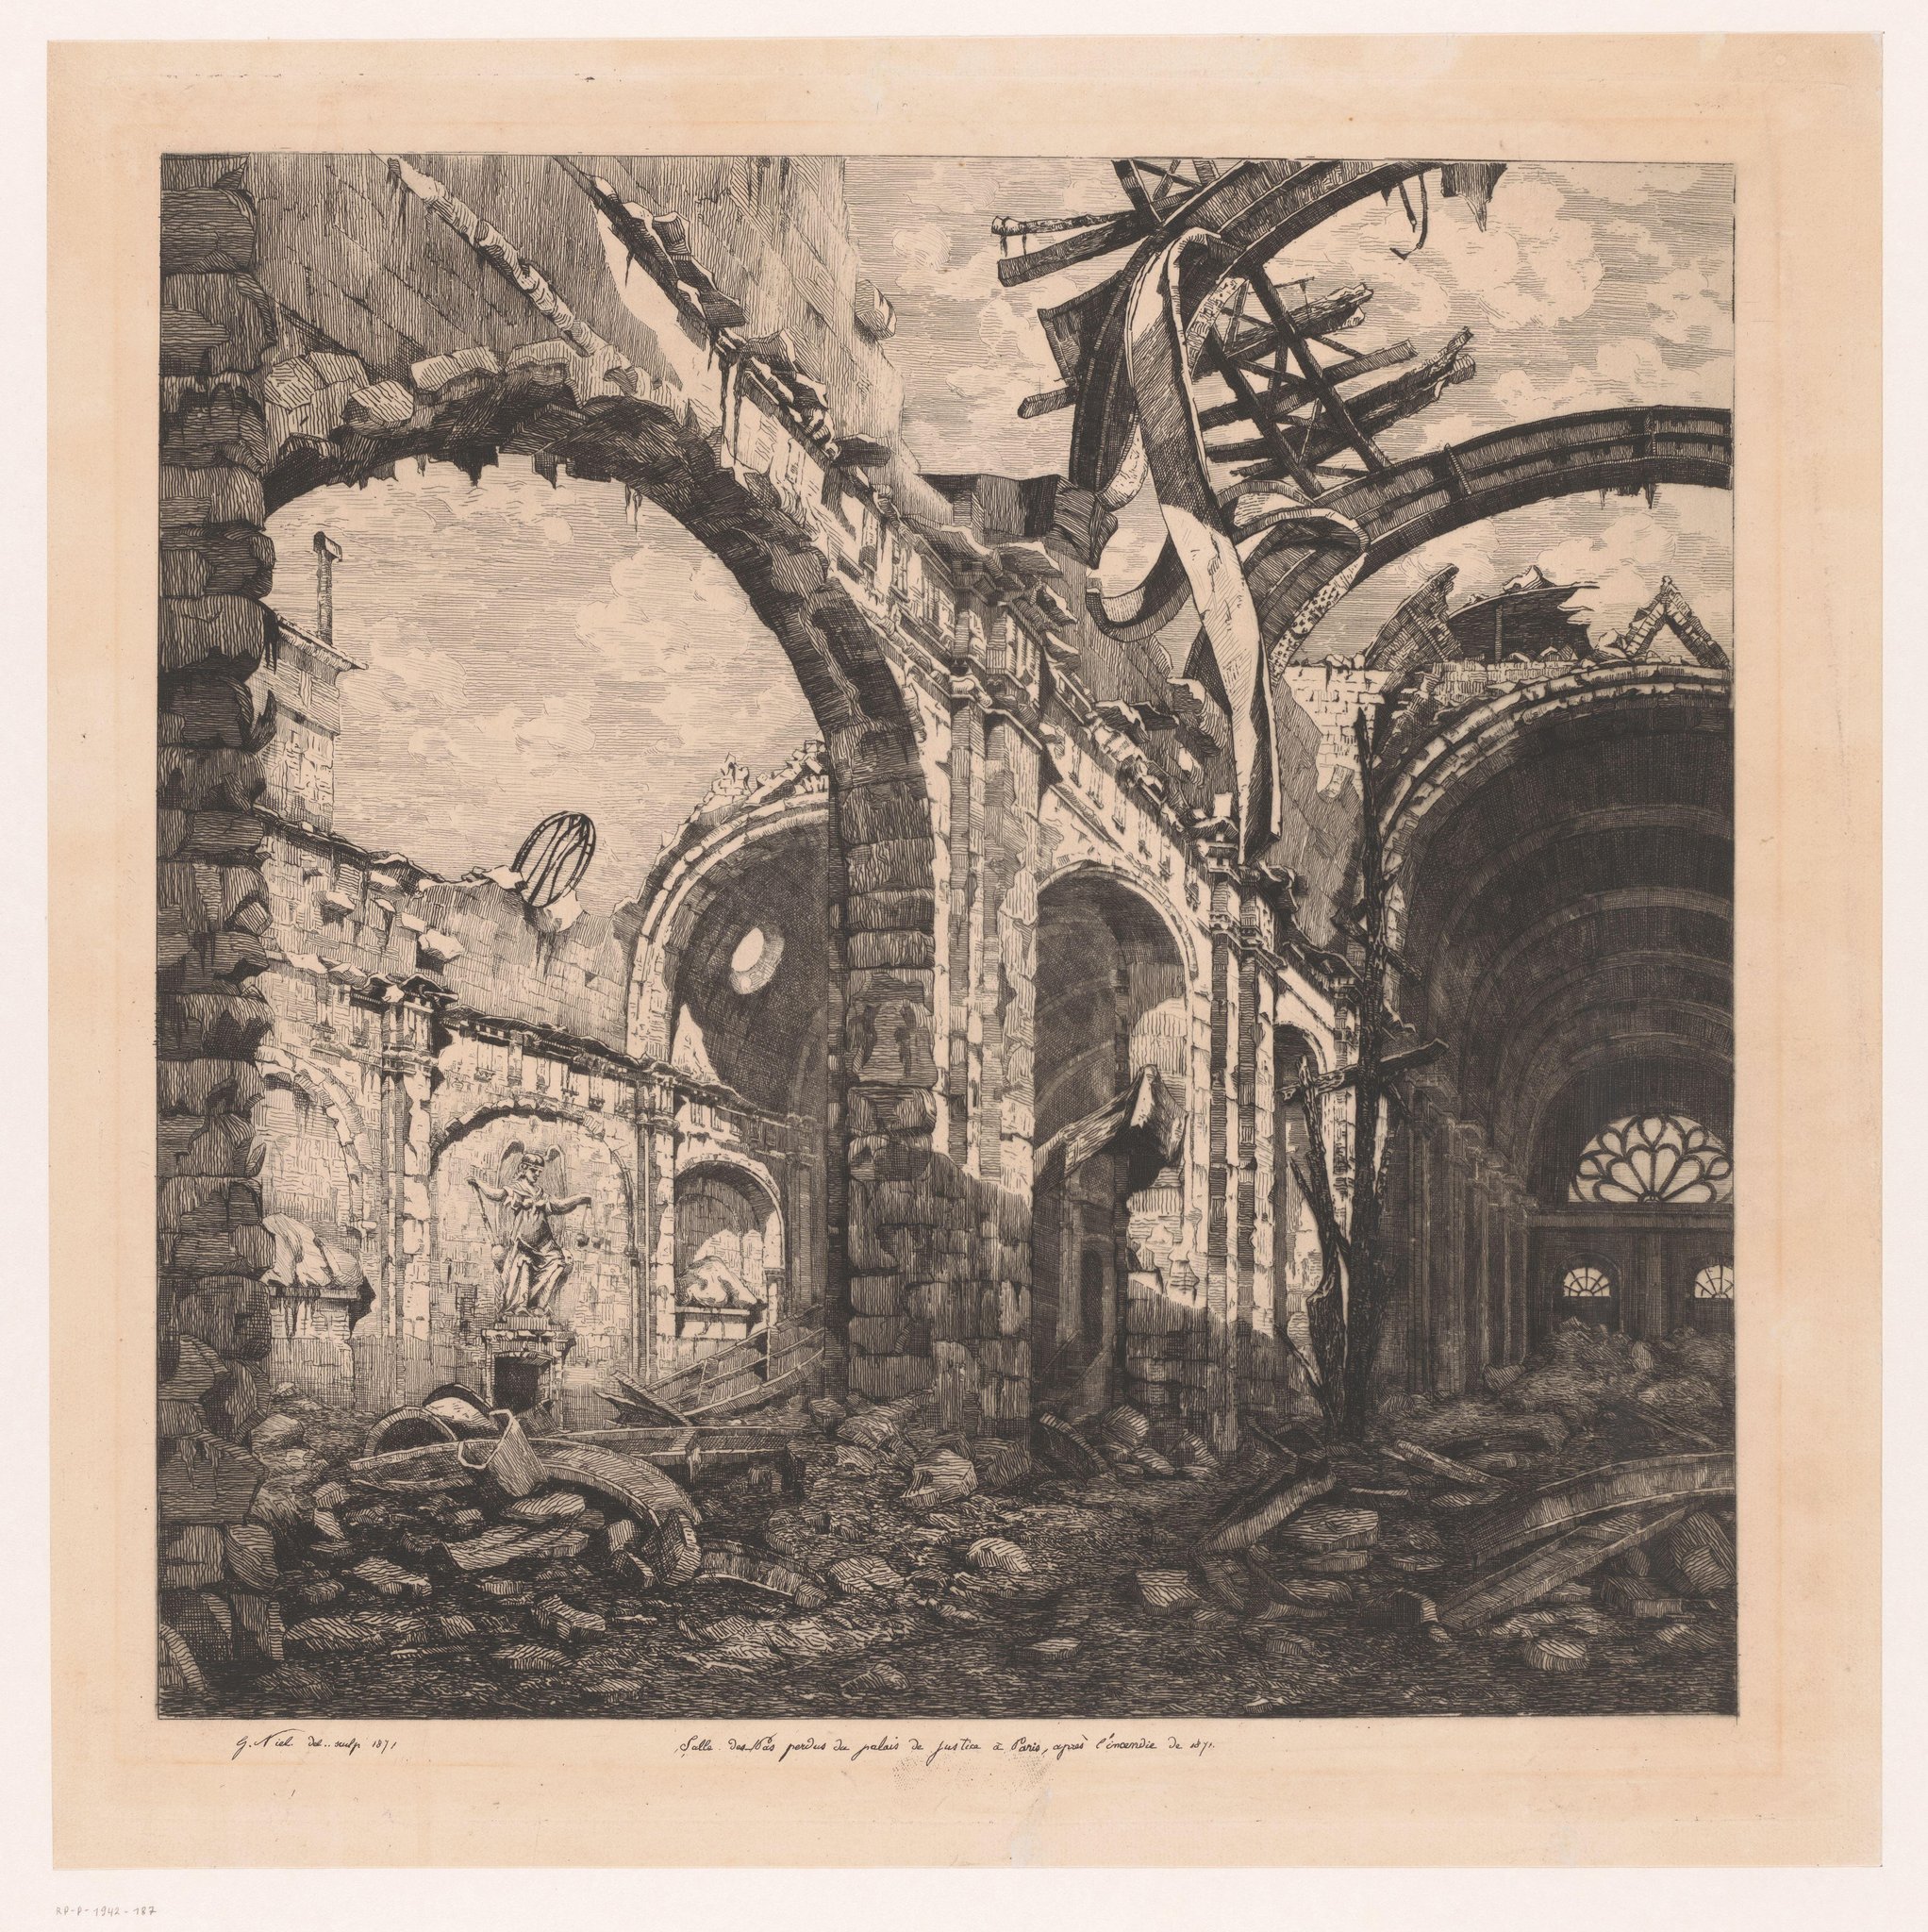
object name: print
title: Salle des pas perdus du Palais de Justice à Paris après l'incendie de 1871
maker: gabrielle-marie niel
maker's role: print maker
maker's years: 1840-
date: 1871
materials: paper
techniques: drypoint, etching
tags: ruin of a building ~ architecture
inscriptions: collector's mark: Lugt 2228